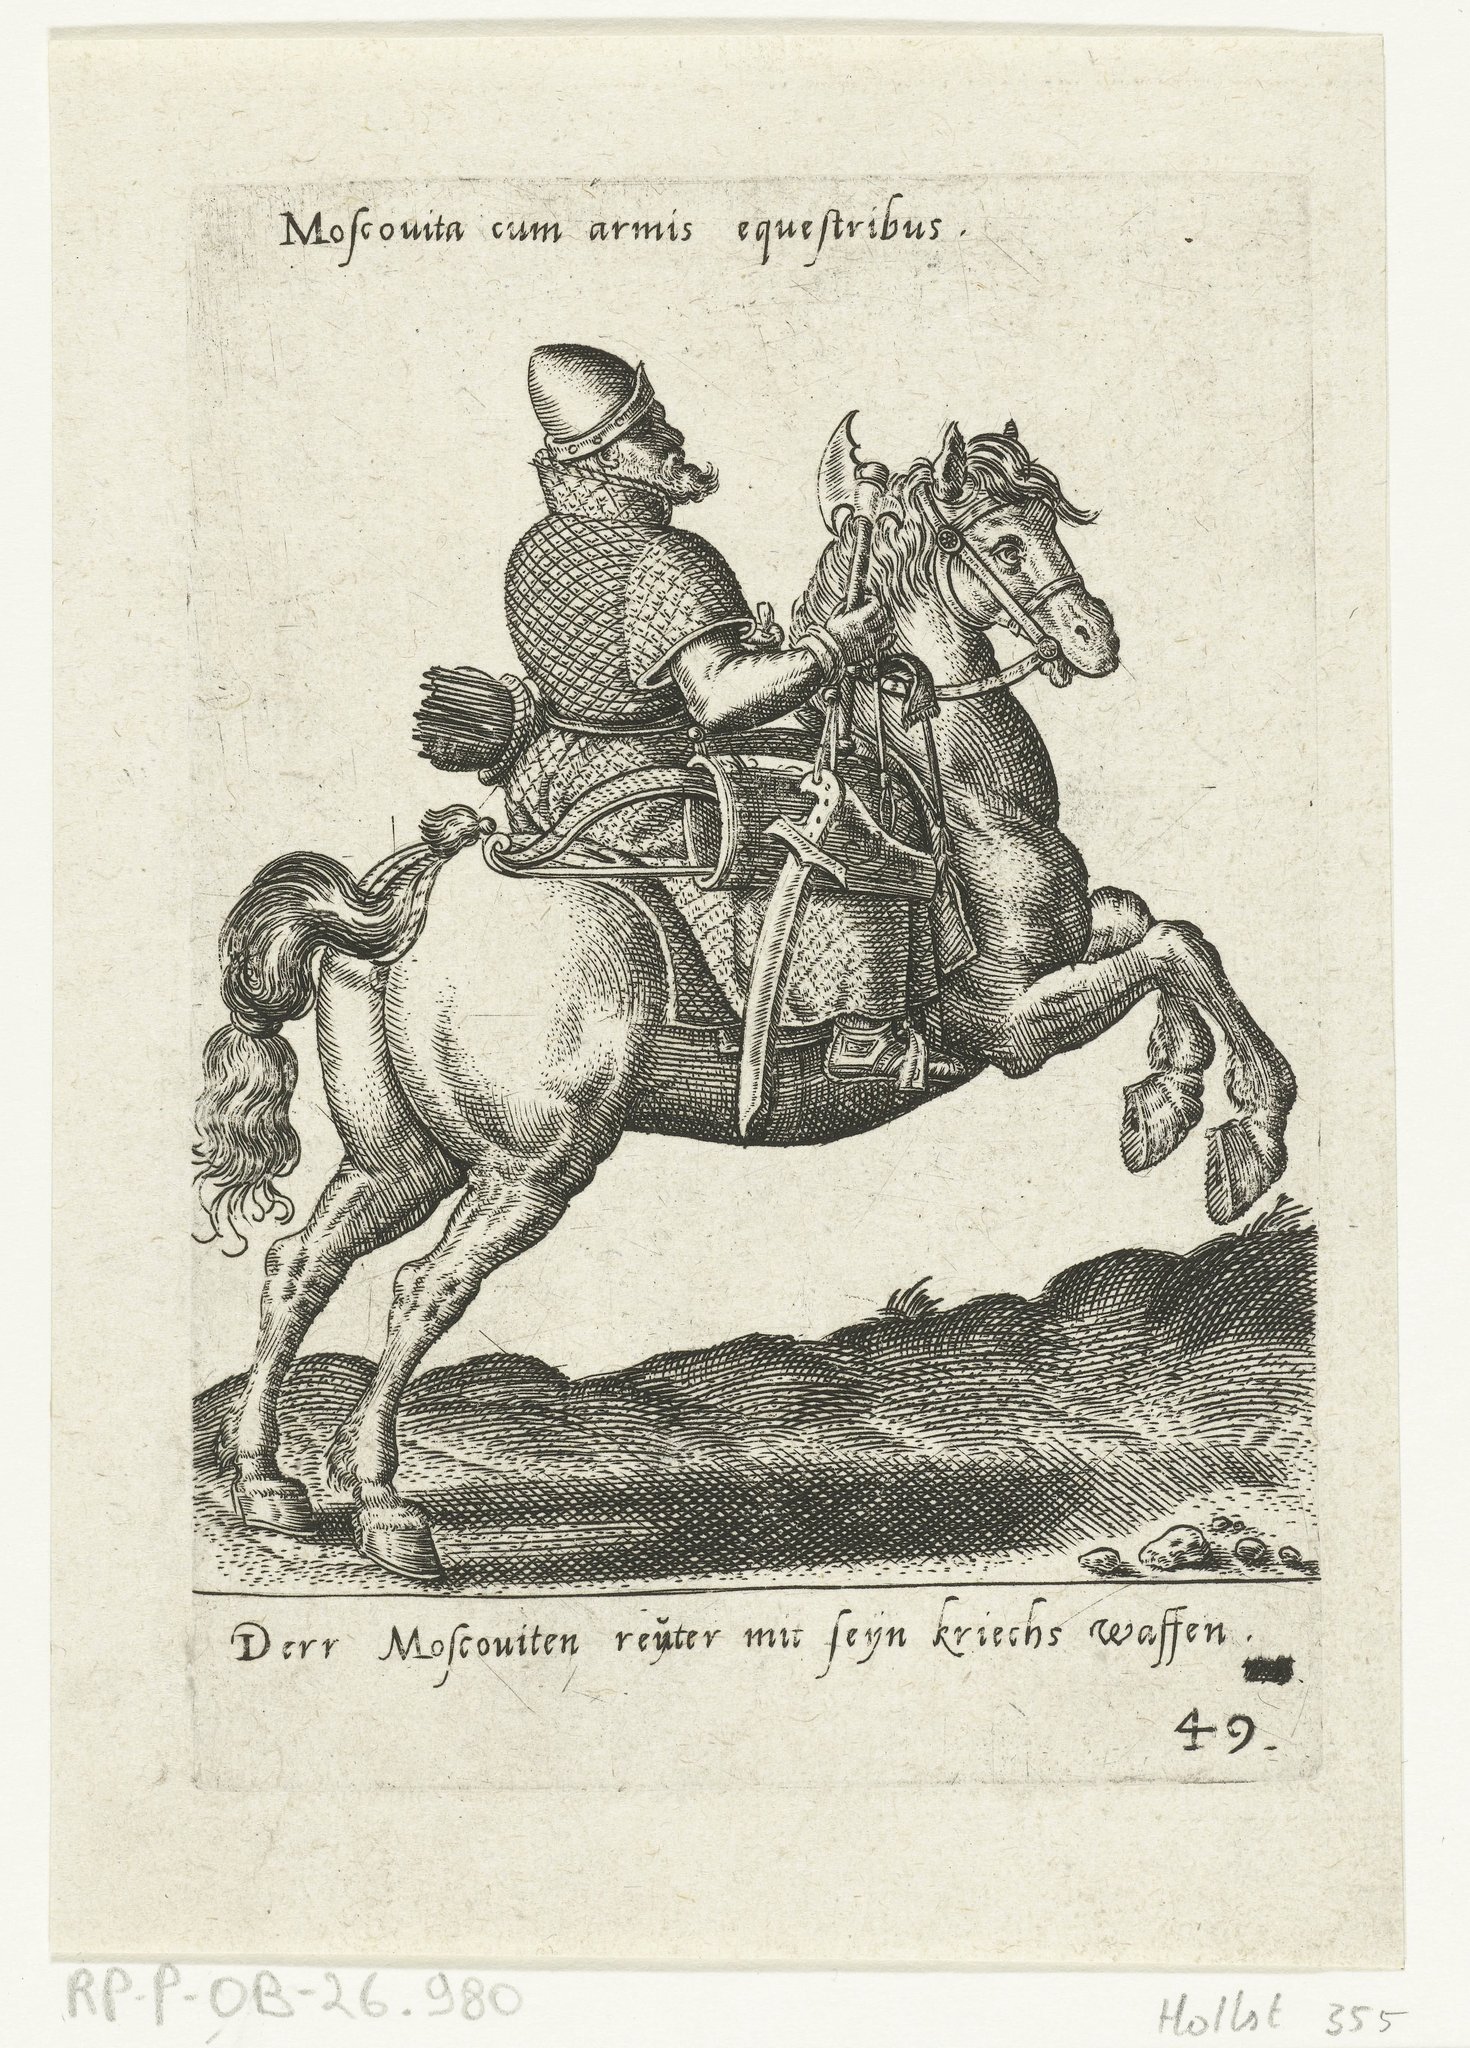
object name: costume print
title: Moskovitische ruiter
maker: abraham de bruyn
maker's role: print maker, publisher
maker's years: 1540-1587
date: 1577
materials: paper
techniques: engraving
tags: warfare; military affairs (+ cavalry, horsemen), folk costume, regional costume, (military) uniforms, europeans (with name)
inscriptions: collector's mark: Lugt 2228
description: Paard en ruiter naar rechts. Het paard is in galop. De ruiter is Russisch gekleed en heeft een bijl in zijn handen. De prent heeft een Duits onderschrift en Latijns opschrift. Prent oorspronkelijk uit 'Equitum descripcio...', 1577.